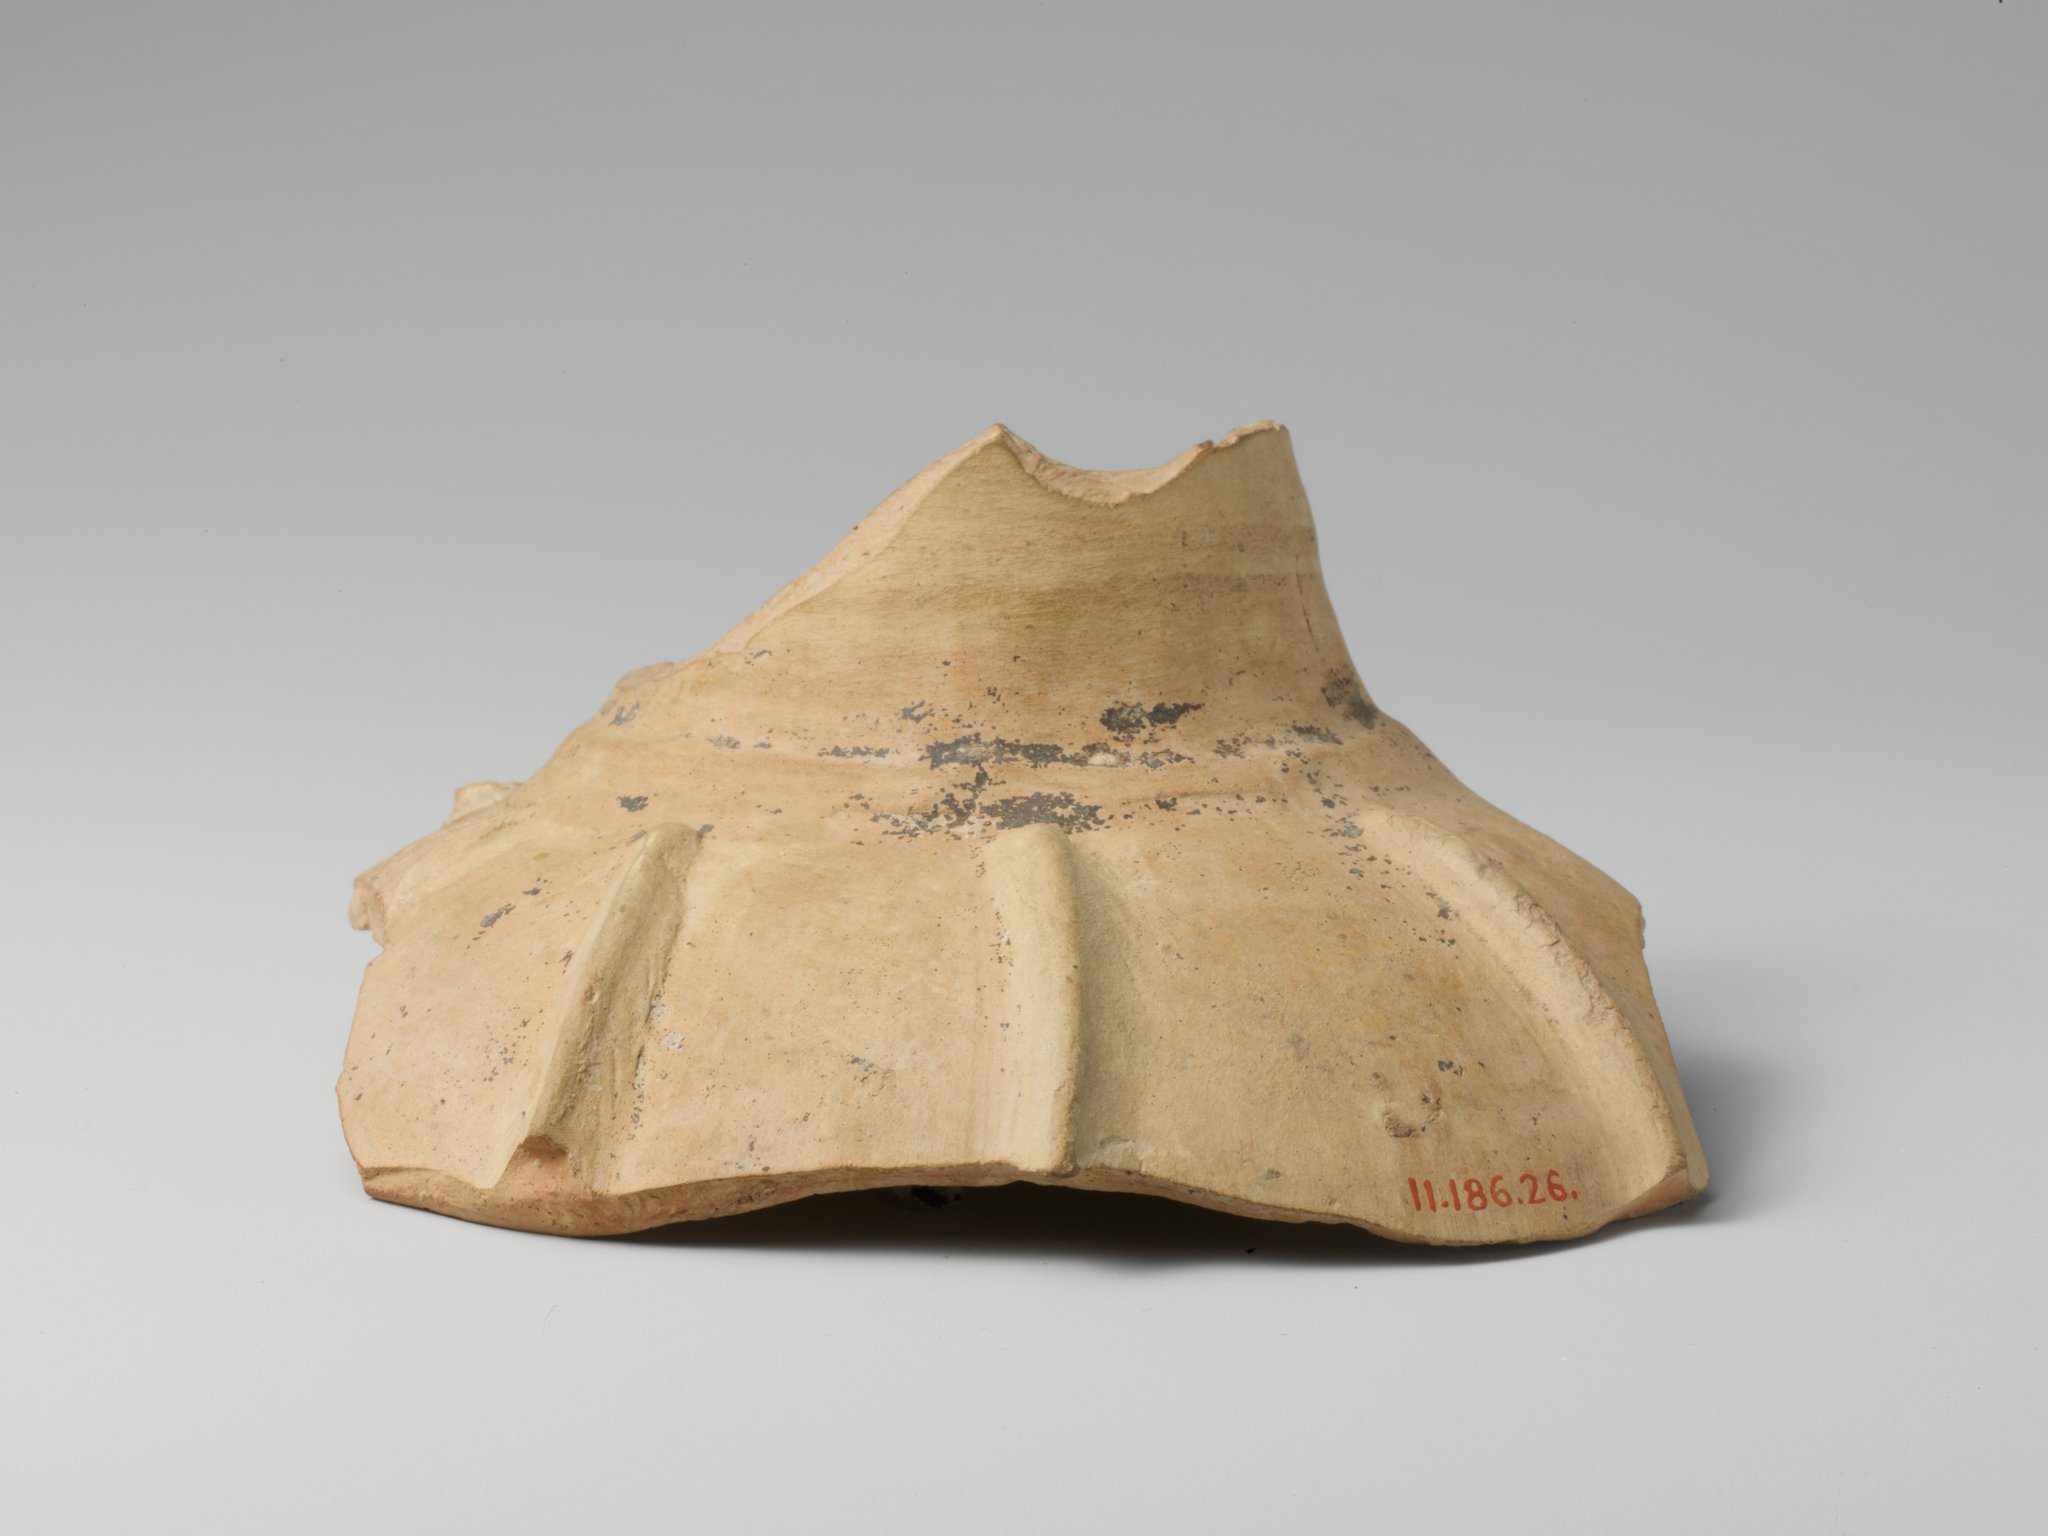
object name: vase fragment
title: Terracotta body and neck fragment of a jug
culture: minoan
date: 2100-1800 BCE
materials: terracotta